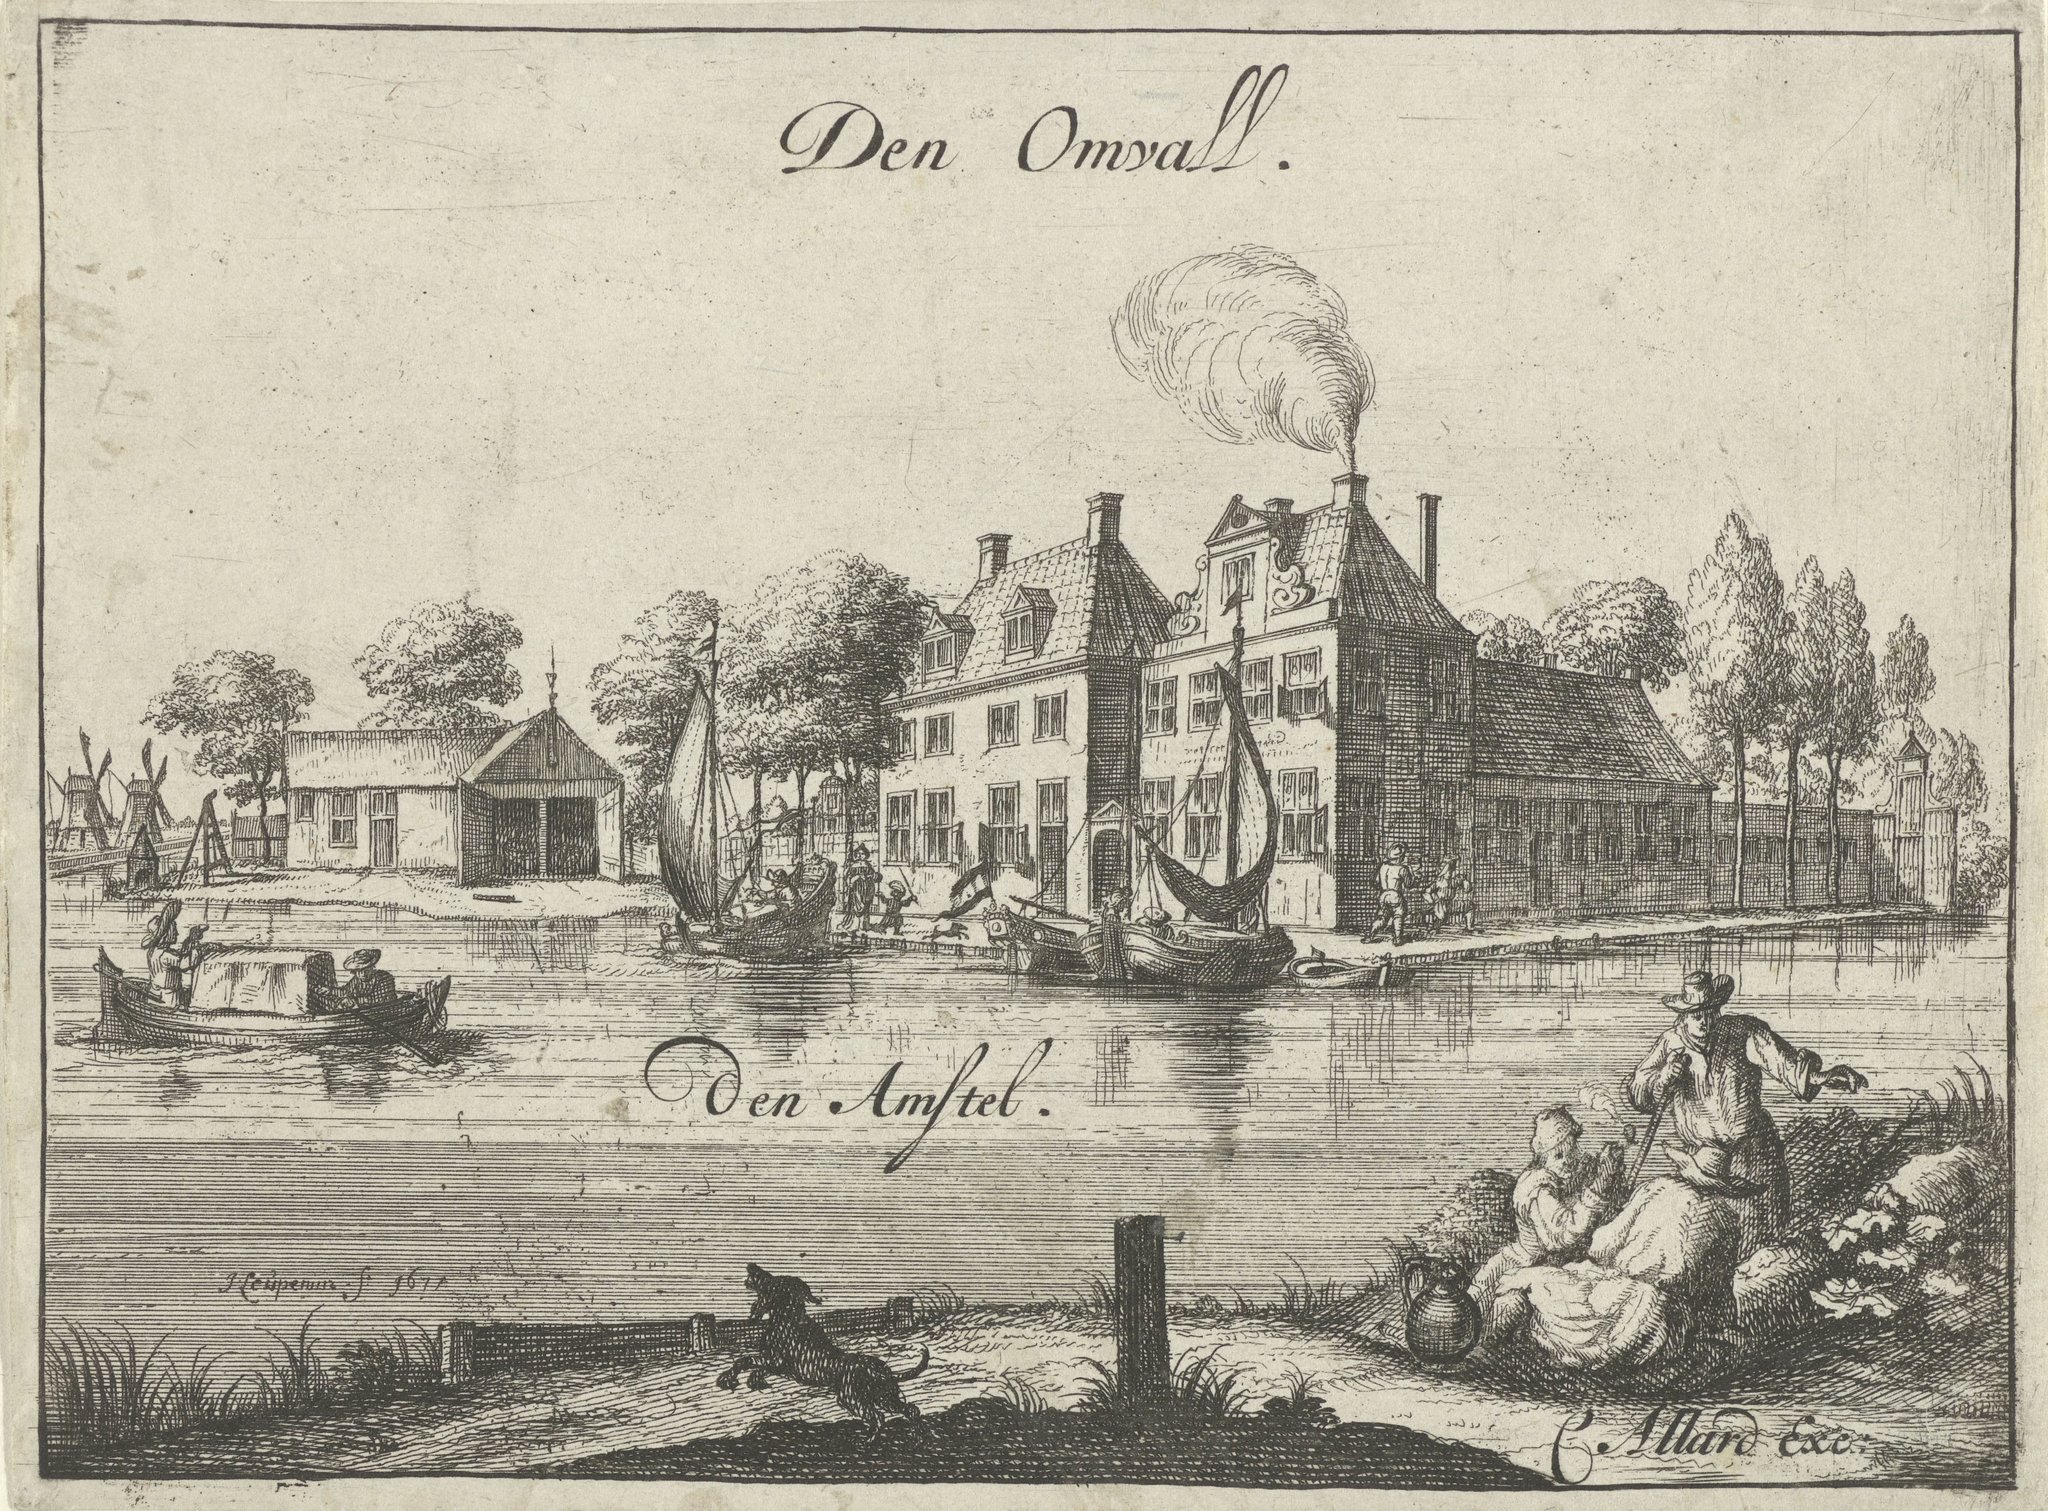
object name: print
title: Den Omvall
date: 1671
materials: paper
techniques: etching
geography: amsterdam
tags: river, hotel, hostelry, inn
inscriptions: collector's mark: Lugt 2165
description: Gezicht op huis De Omval, gelegen op de punt van de gelijknamige landtong tussen de zuidelijke arm van de ringvaart van de Watergraafsmeer en de Amstel. Rechts op de voorgrond drie converserende figuren. De prent maakt deel uit van een zesdelige serie met voorstellingen van aan de Vecht en Amstel gelegen kastelen en herbergen.